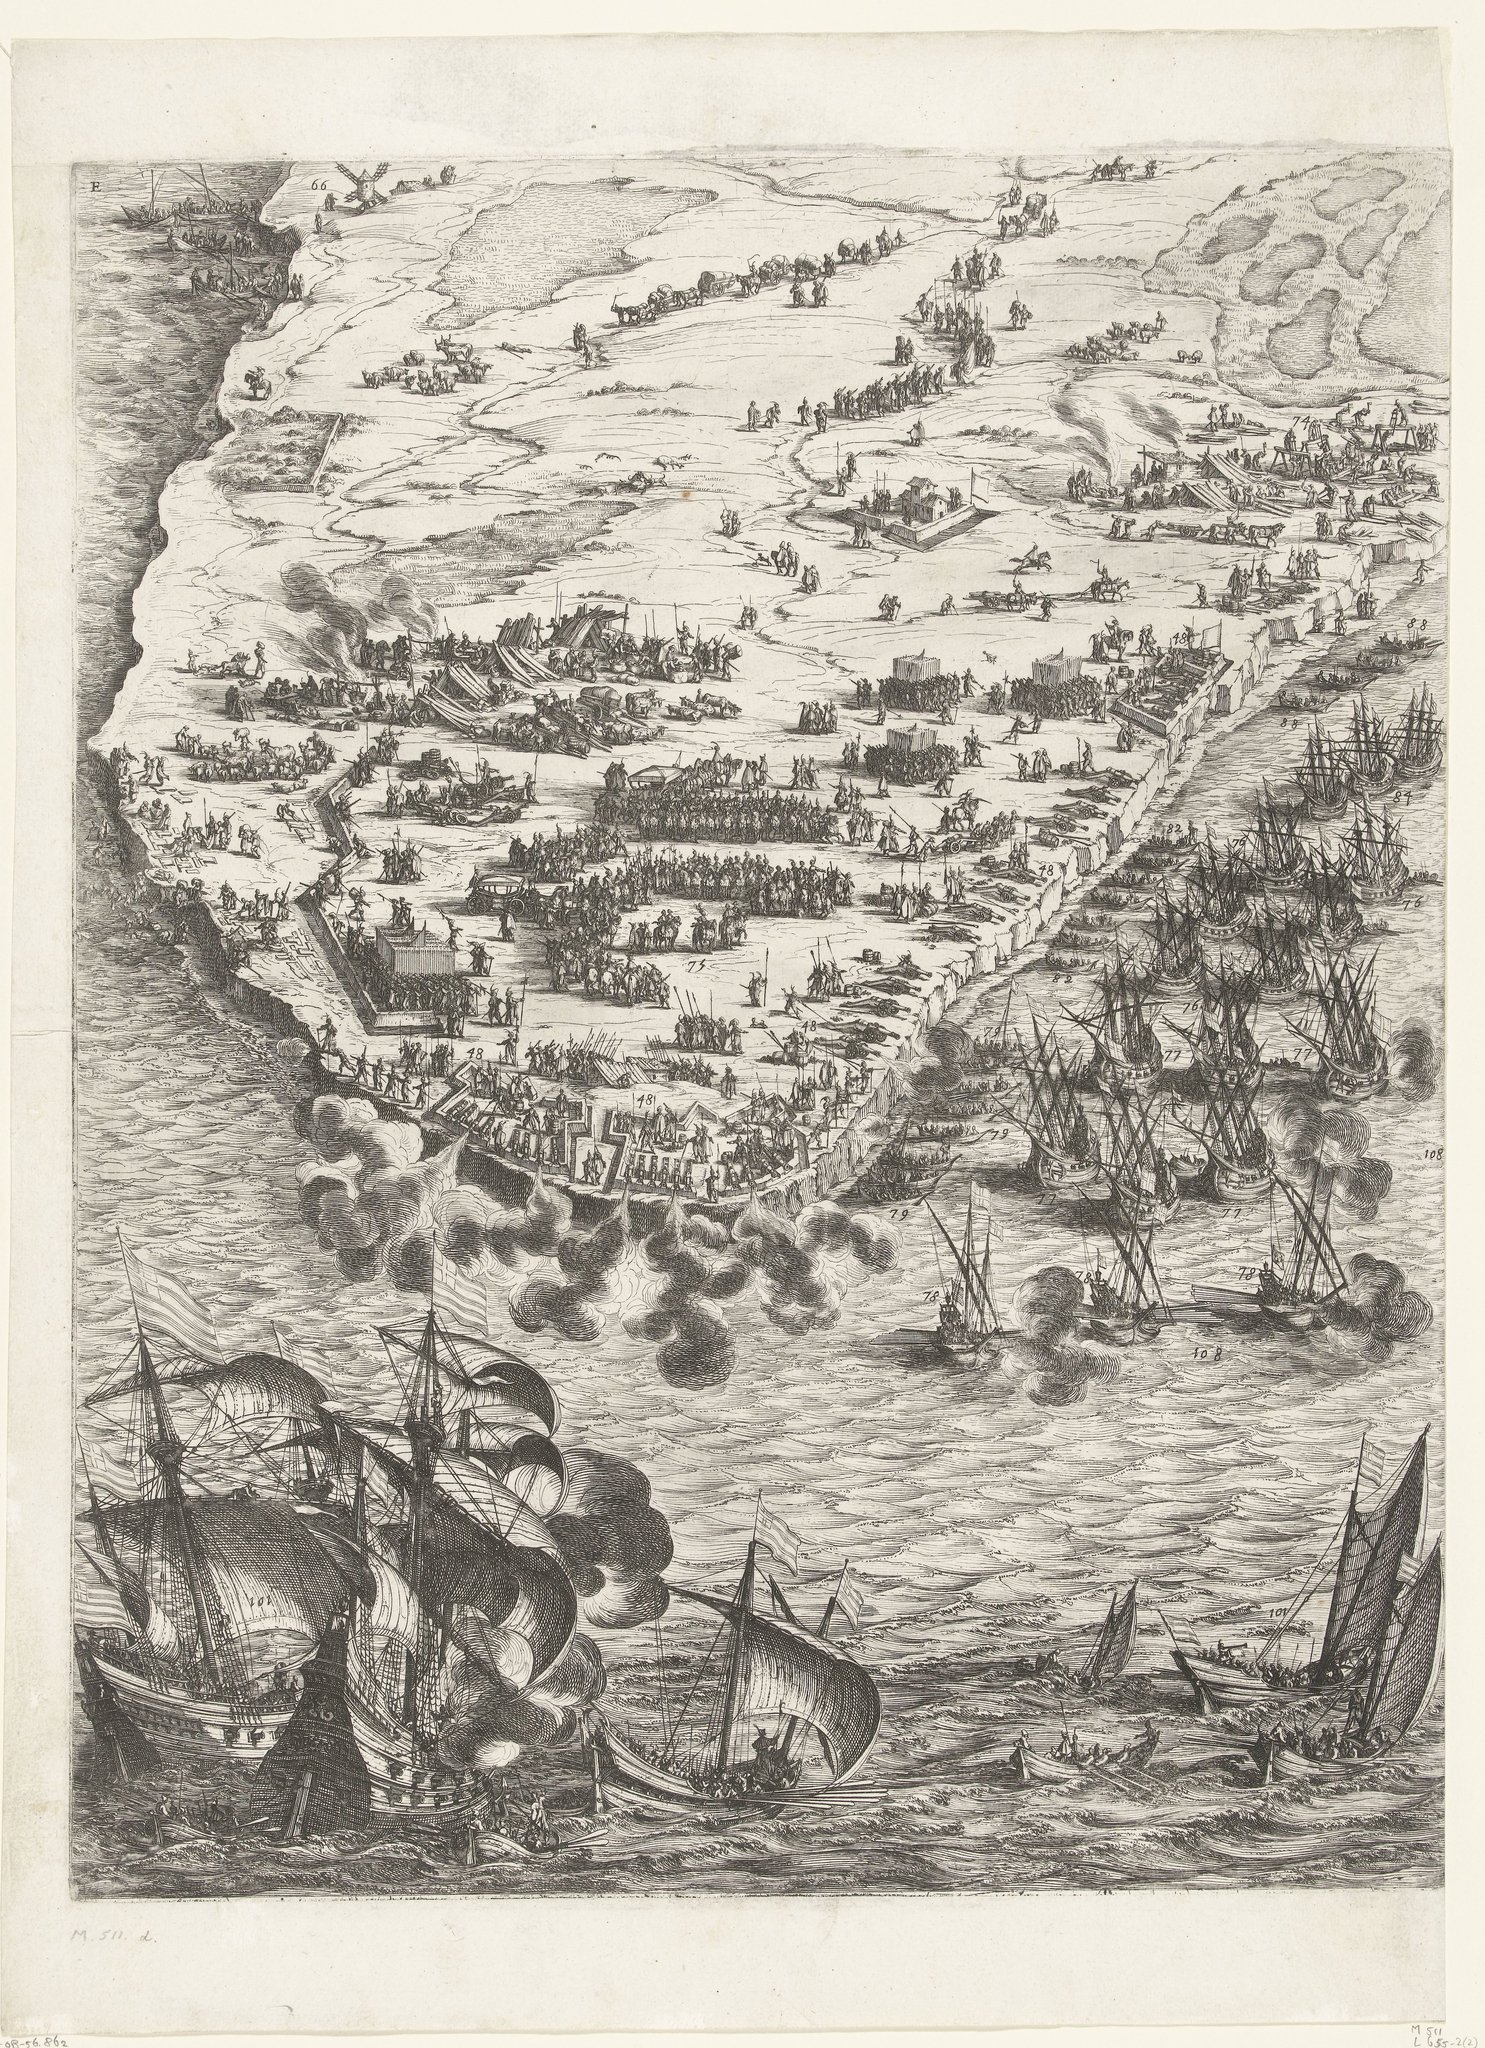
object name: history print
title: Beleg van La Rochelle, september 1627-oktober 1628 (centrale kaart, deel linksonder)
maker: jacques callot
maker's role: draughtsman, print maker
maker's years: 1592-1635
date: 1628-1631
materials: paper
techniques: etching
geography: paris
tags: maps of separate countries or regions, ships (in general), warfare; military affairs (+ naval force), siege, temporary fortifications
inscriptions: collector's mark: Lugt 240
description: Zestiende deel (centrale kaart, deel linksonder) van een prent van het beleg van het hugenotenbolwerk La Rochelle in de jaren 1627 en 1628, dat werd uitgevoerd in opdracht van de Franse koning door het Franse leger onder aanvoering van kardinaal Richelieu. Op dit blad een deel van het gebied om La Rochelle heen, bevolkt door vele figuurtjes. Hier en daar zijn belegeringswerken (schansen, versterkingen, wallen e.d.) herkenbaar. Op de voorgrond en rechts vele schepen voor de kust.